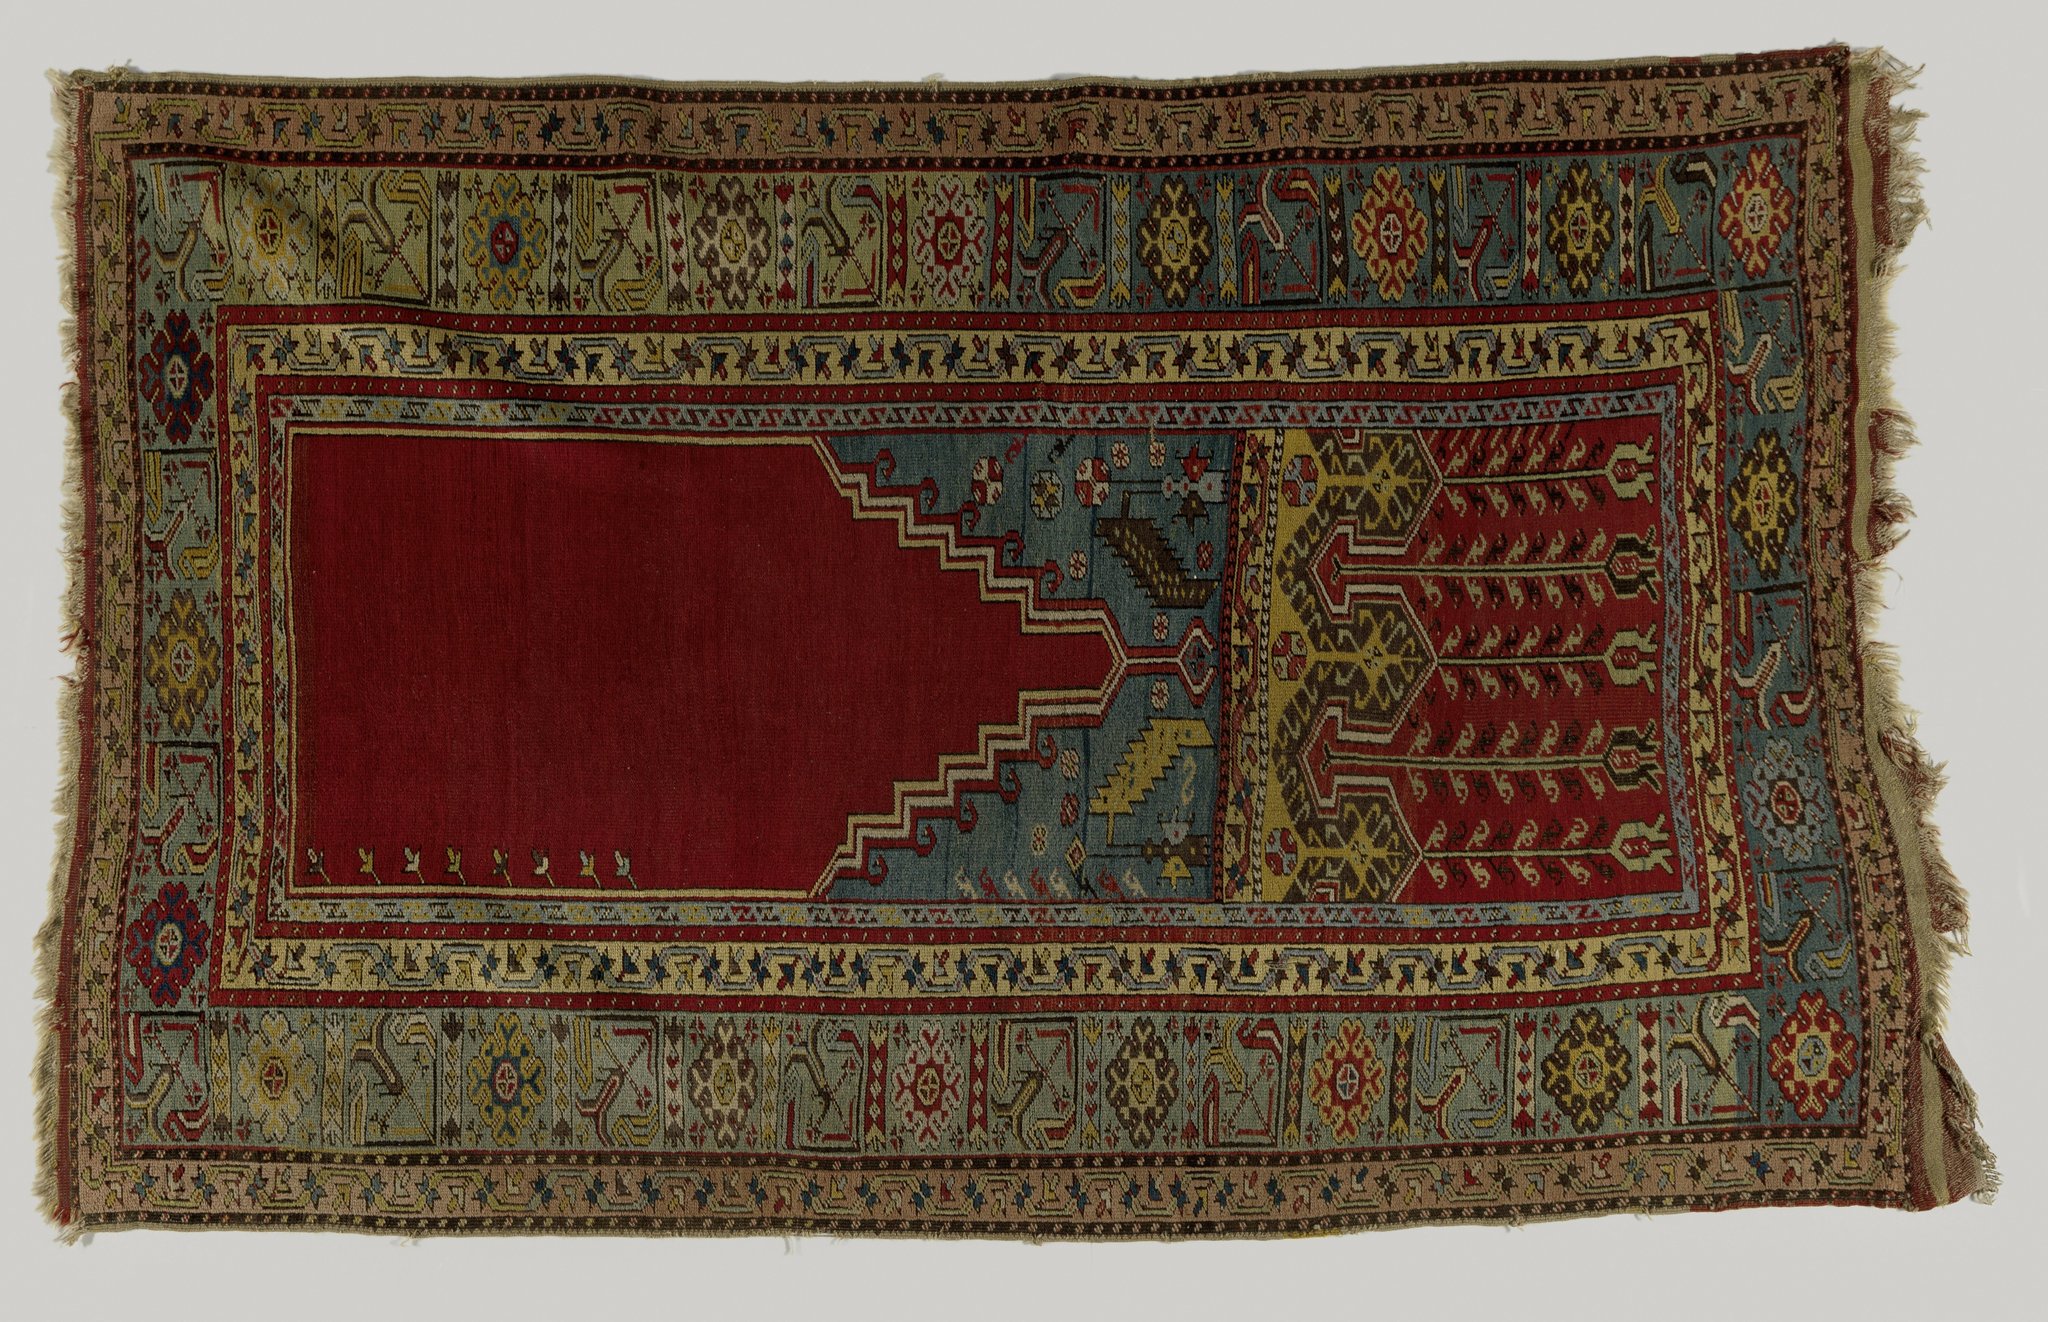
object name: oriental rug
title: Oosters tapijt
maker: Anonymous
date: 1800-1815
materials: wool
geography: asia minor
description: Oosters tapijt, bidkleed, van geknoopte wol, versierd met een terra-rode mihrab, met een hoge trapgeveltop. Het bovenveld is versierd met tulpen. Rondom drie randen waarvan de middelste versierd met bloemen.